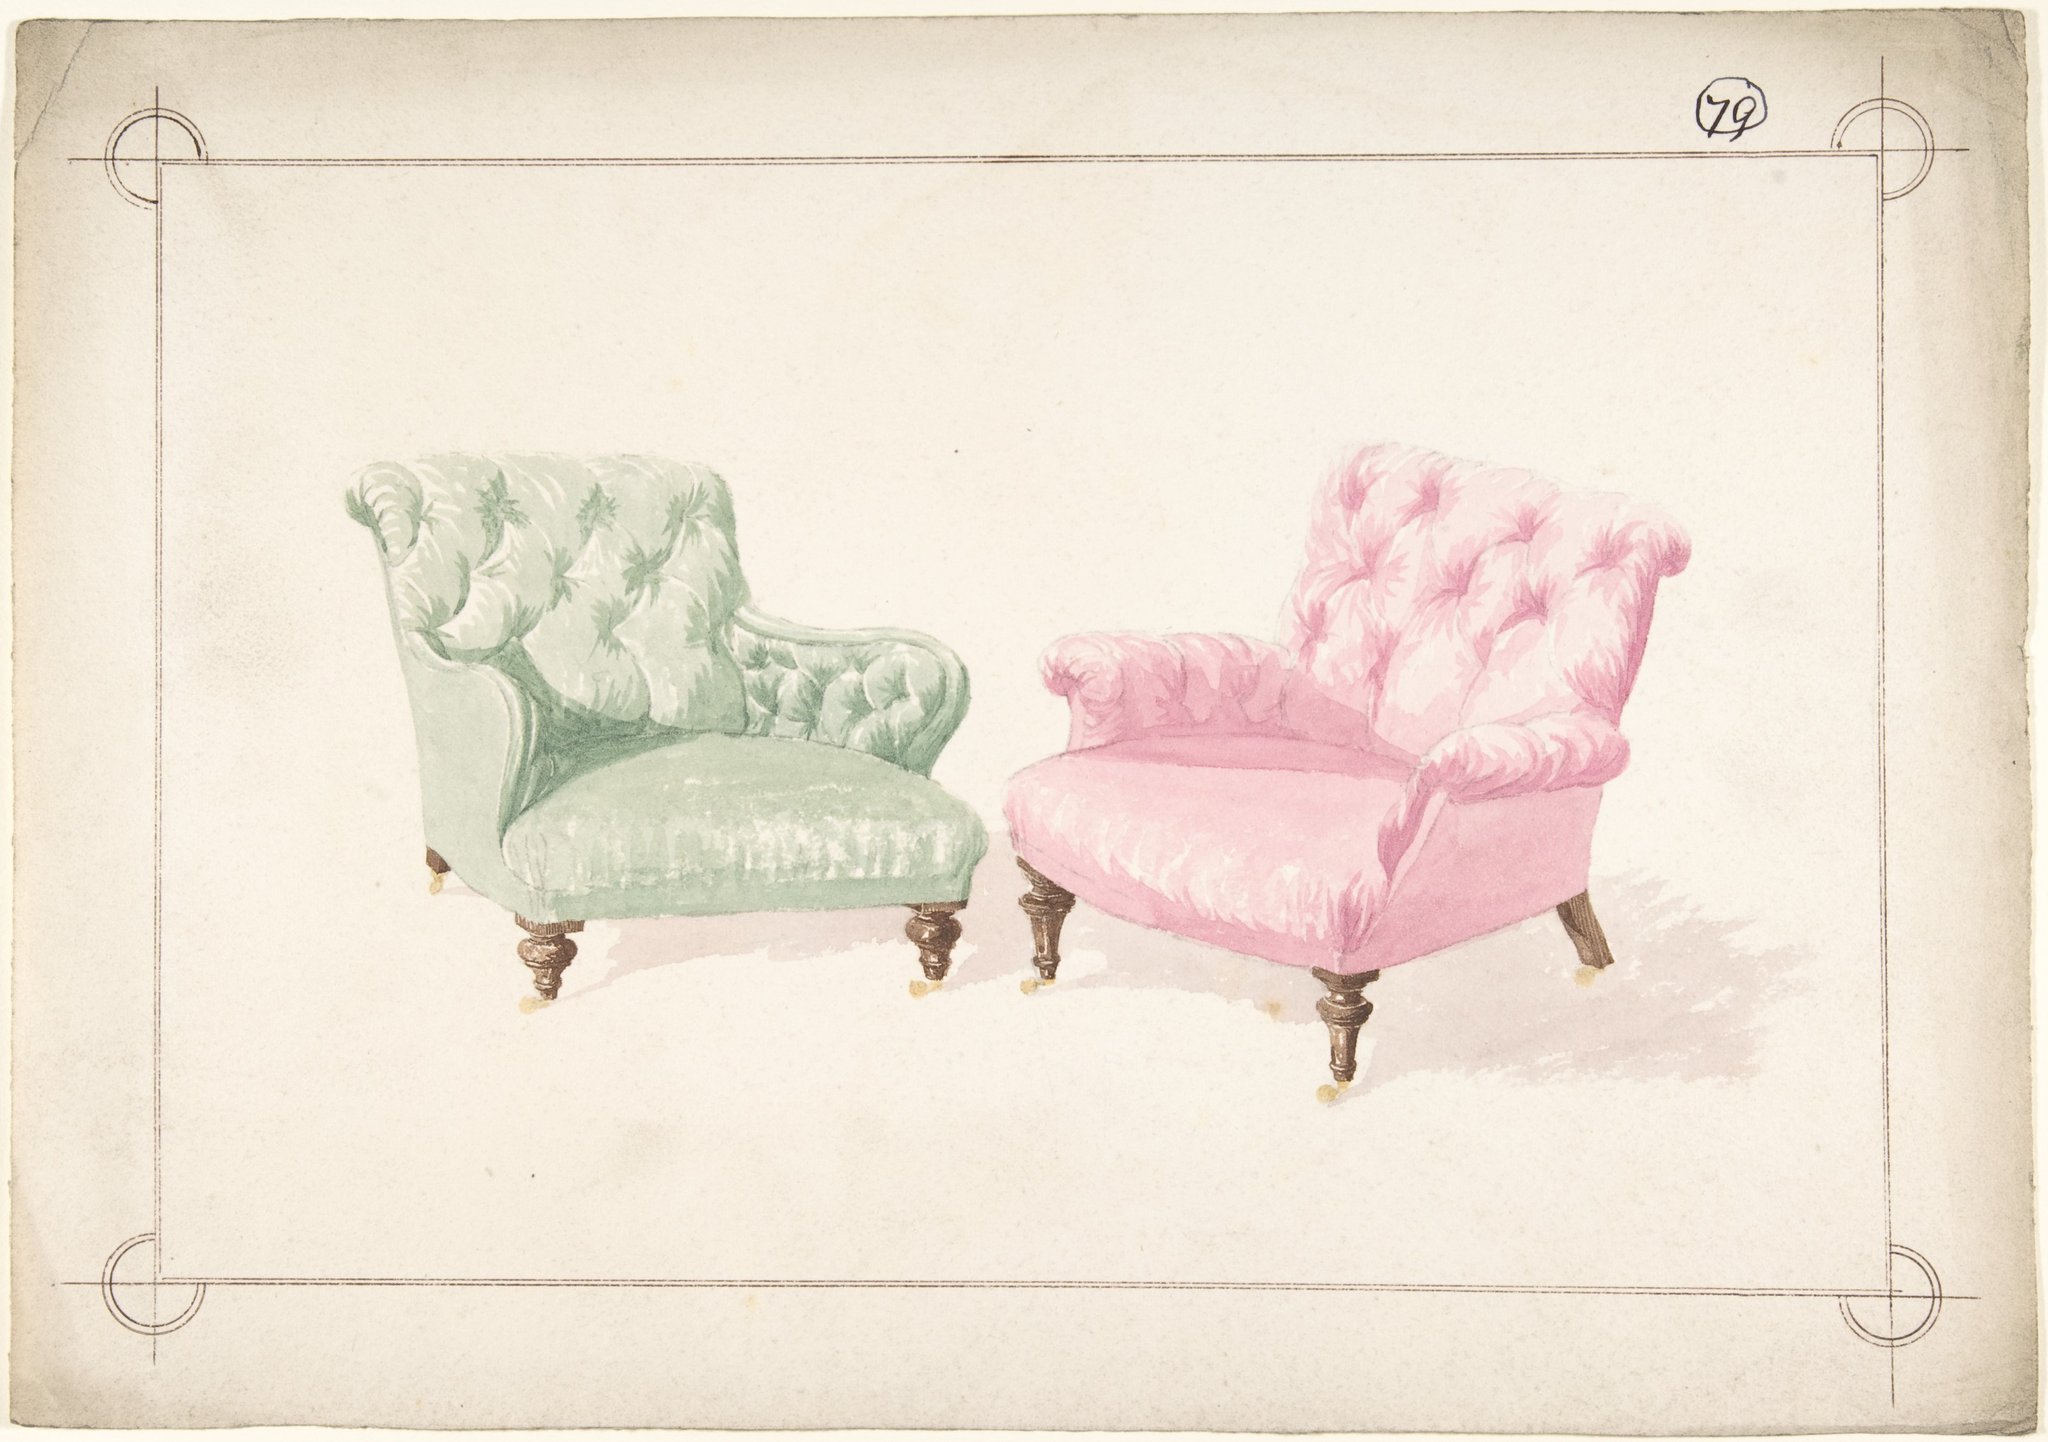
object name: drawing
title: Designs for Two Chairs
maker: charles hindley and sons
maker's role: artist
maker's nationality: british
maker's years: 1841-1917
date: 1841-1884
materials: graphite, watercolor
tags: chairs